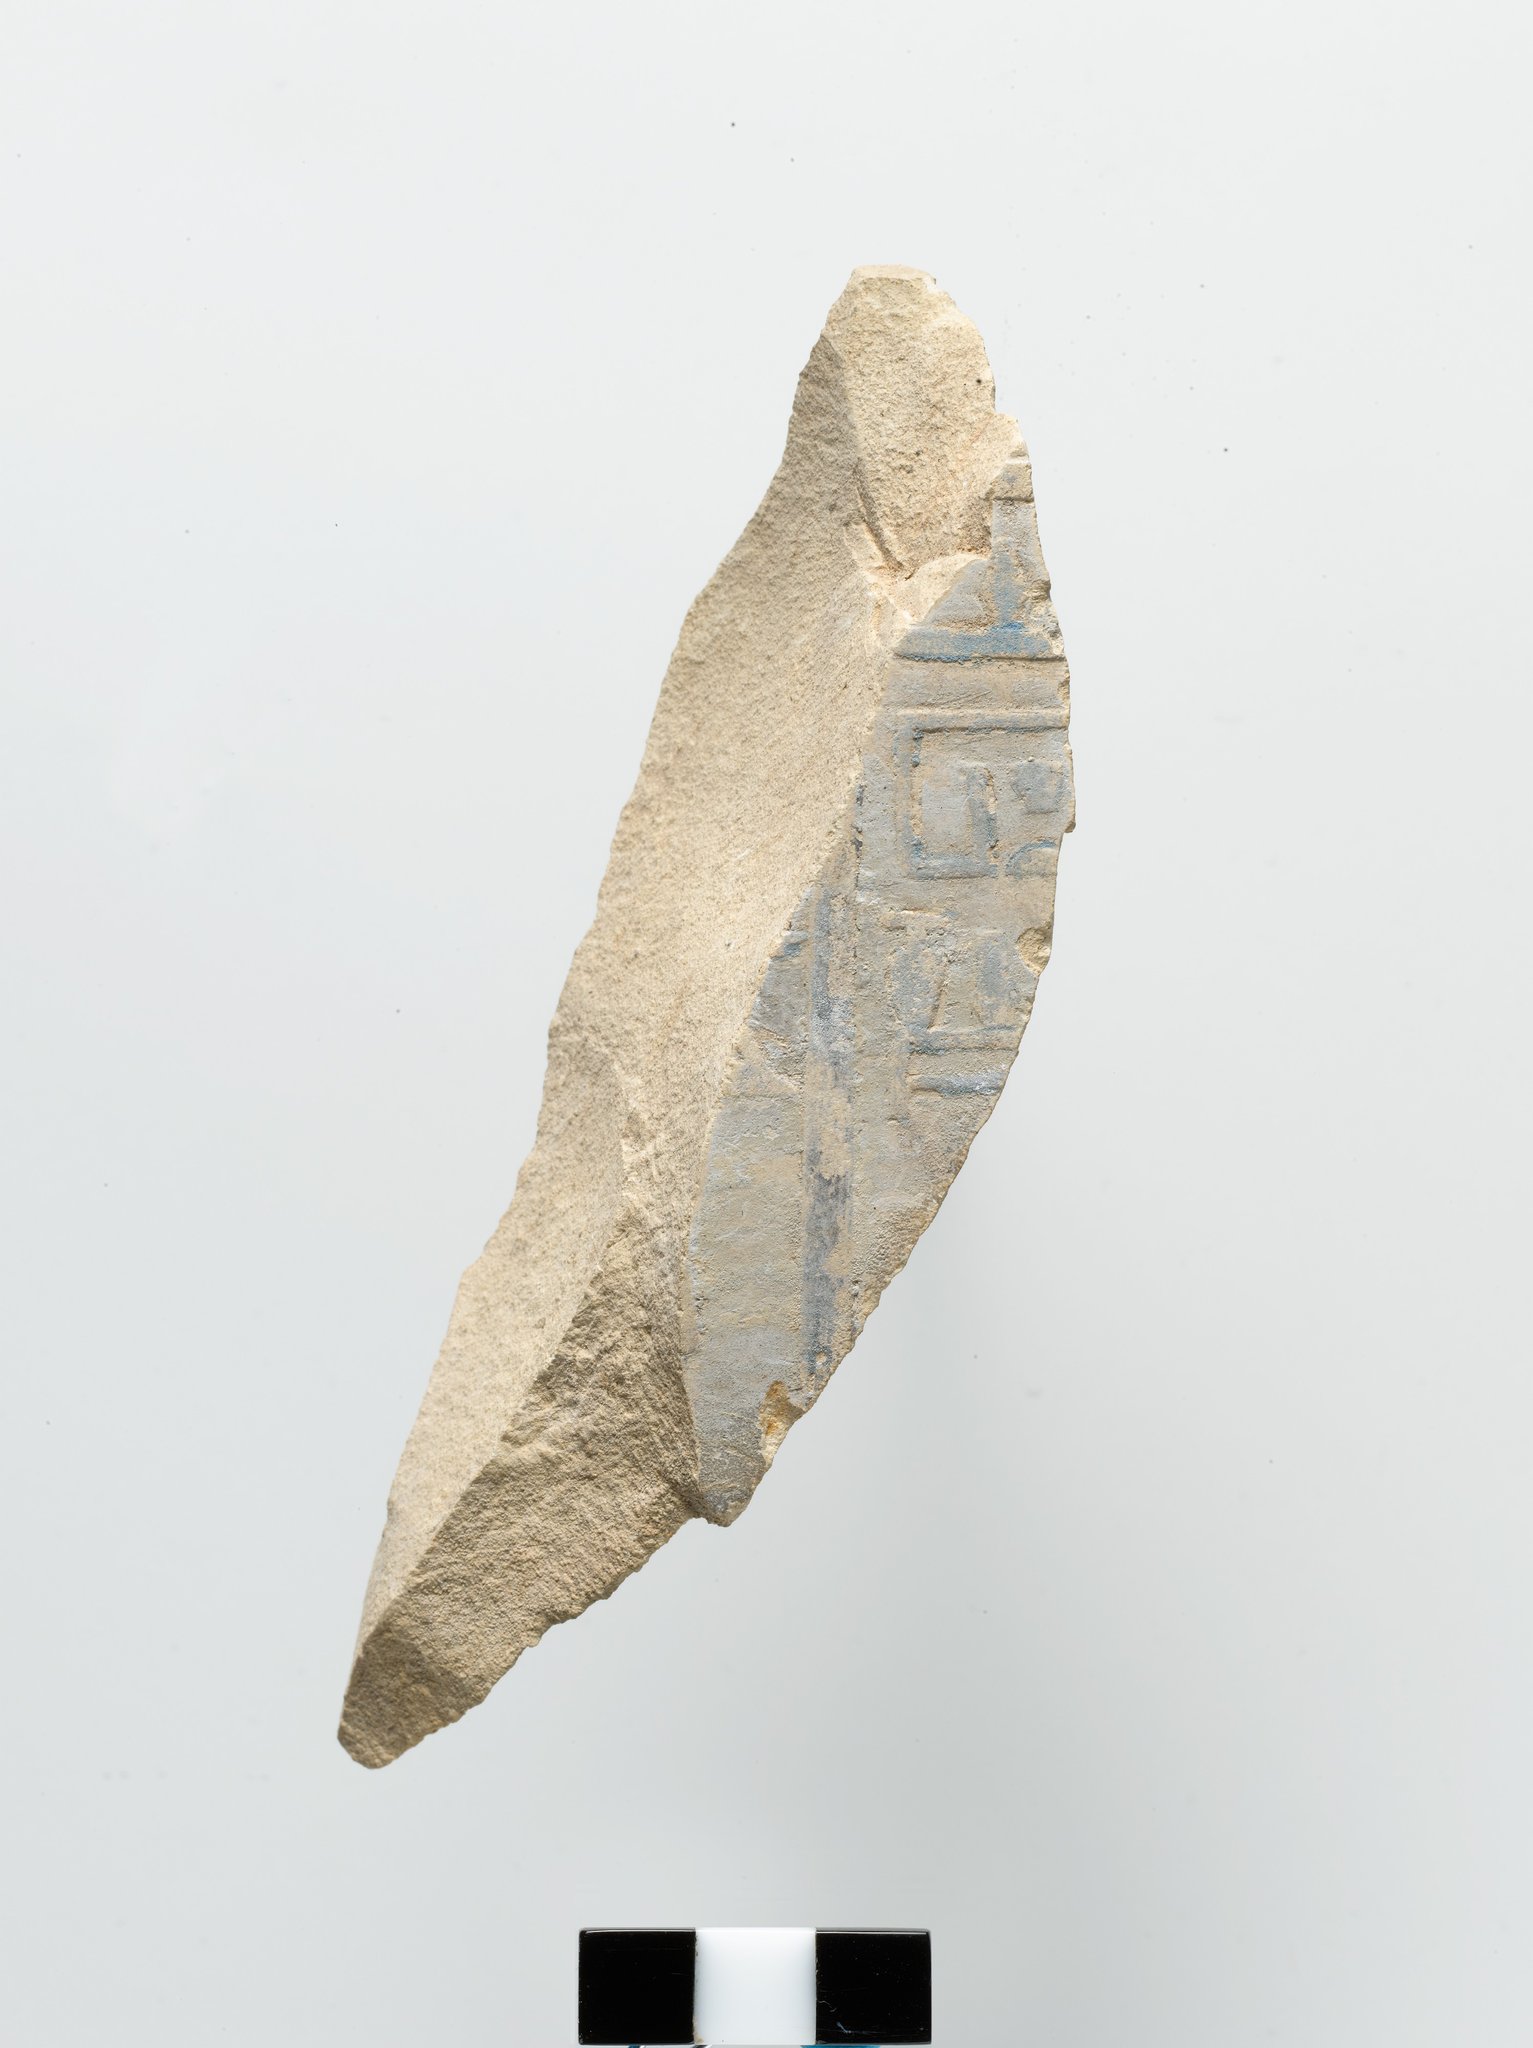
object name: relief fragment, tomb of meketre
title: Relief fragment from the tomb of Meketre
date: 1981-1975 BCE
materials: limestone, paint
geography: egypt